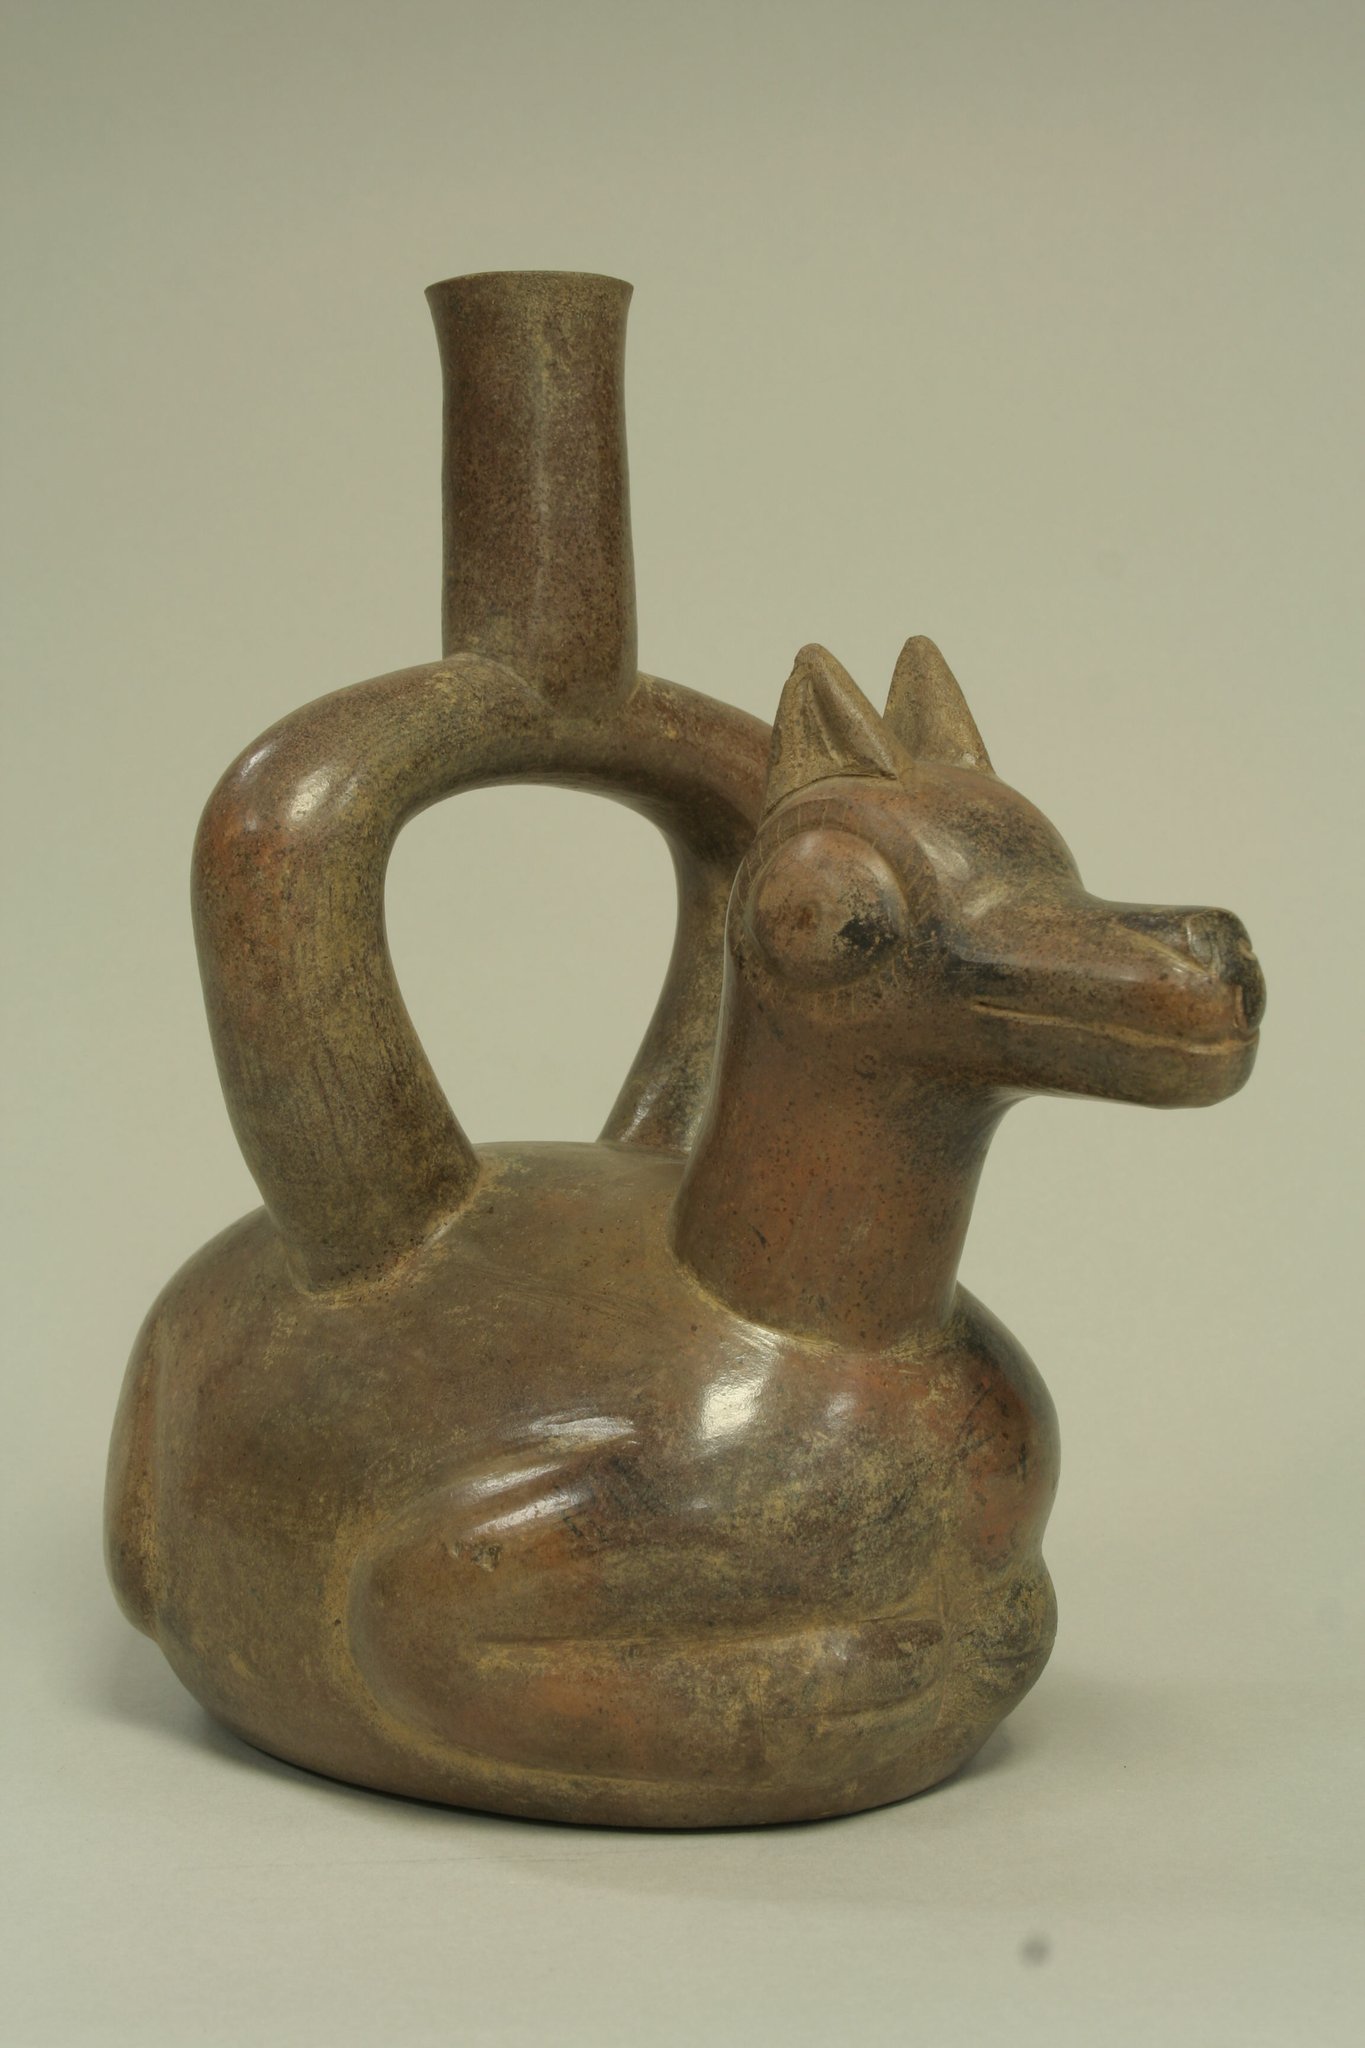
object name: bottle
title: Stirrup-Spout Bottle: Llama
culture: cupisnique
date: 1200-401 BCE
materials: ceramic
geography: peru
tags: animals